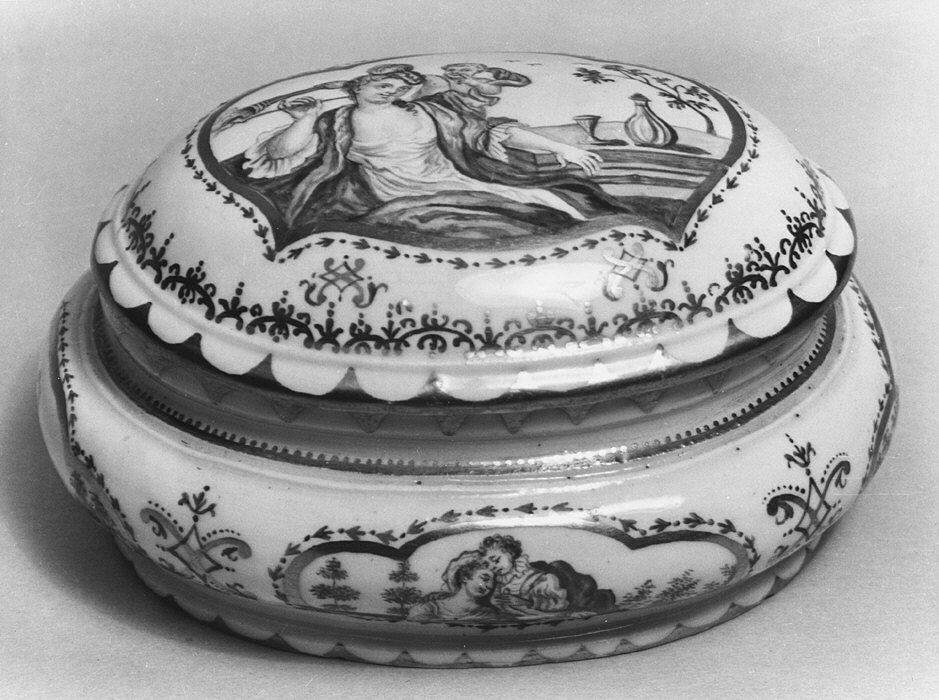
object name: sugar box with cover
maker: meissen manufactory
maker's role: manufactory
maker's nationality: german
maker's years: 1710-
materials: hard paste porcelain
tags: women